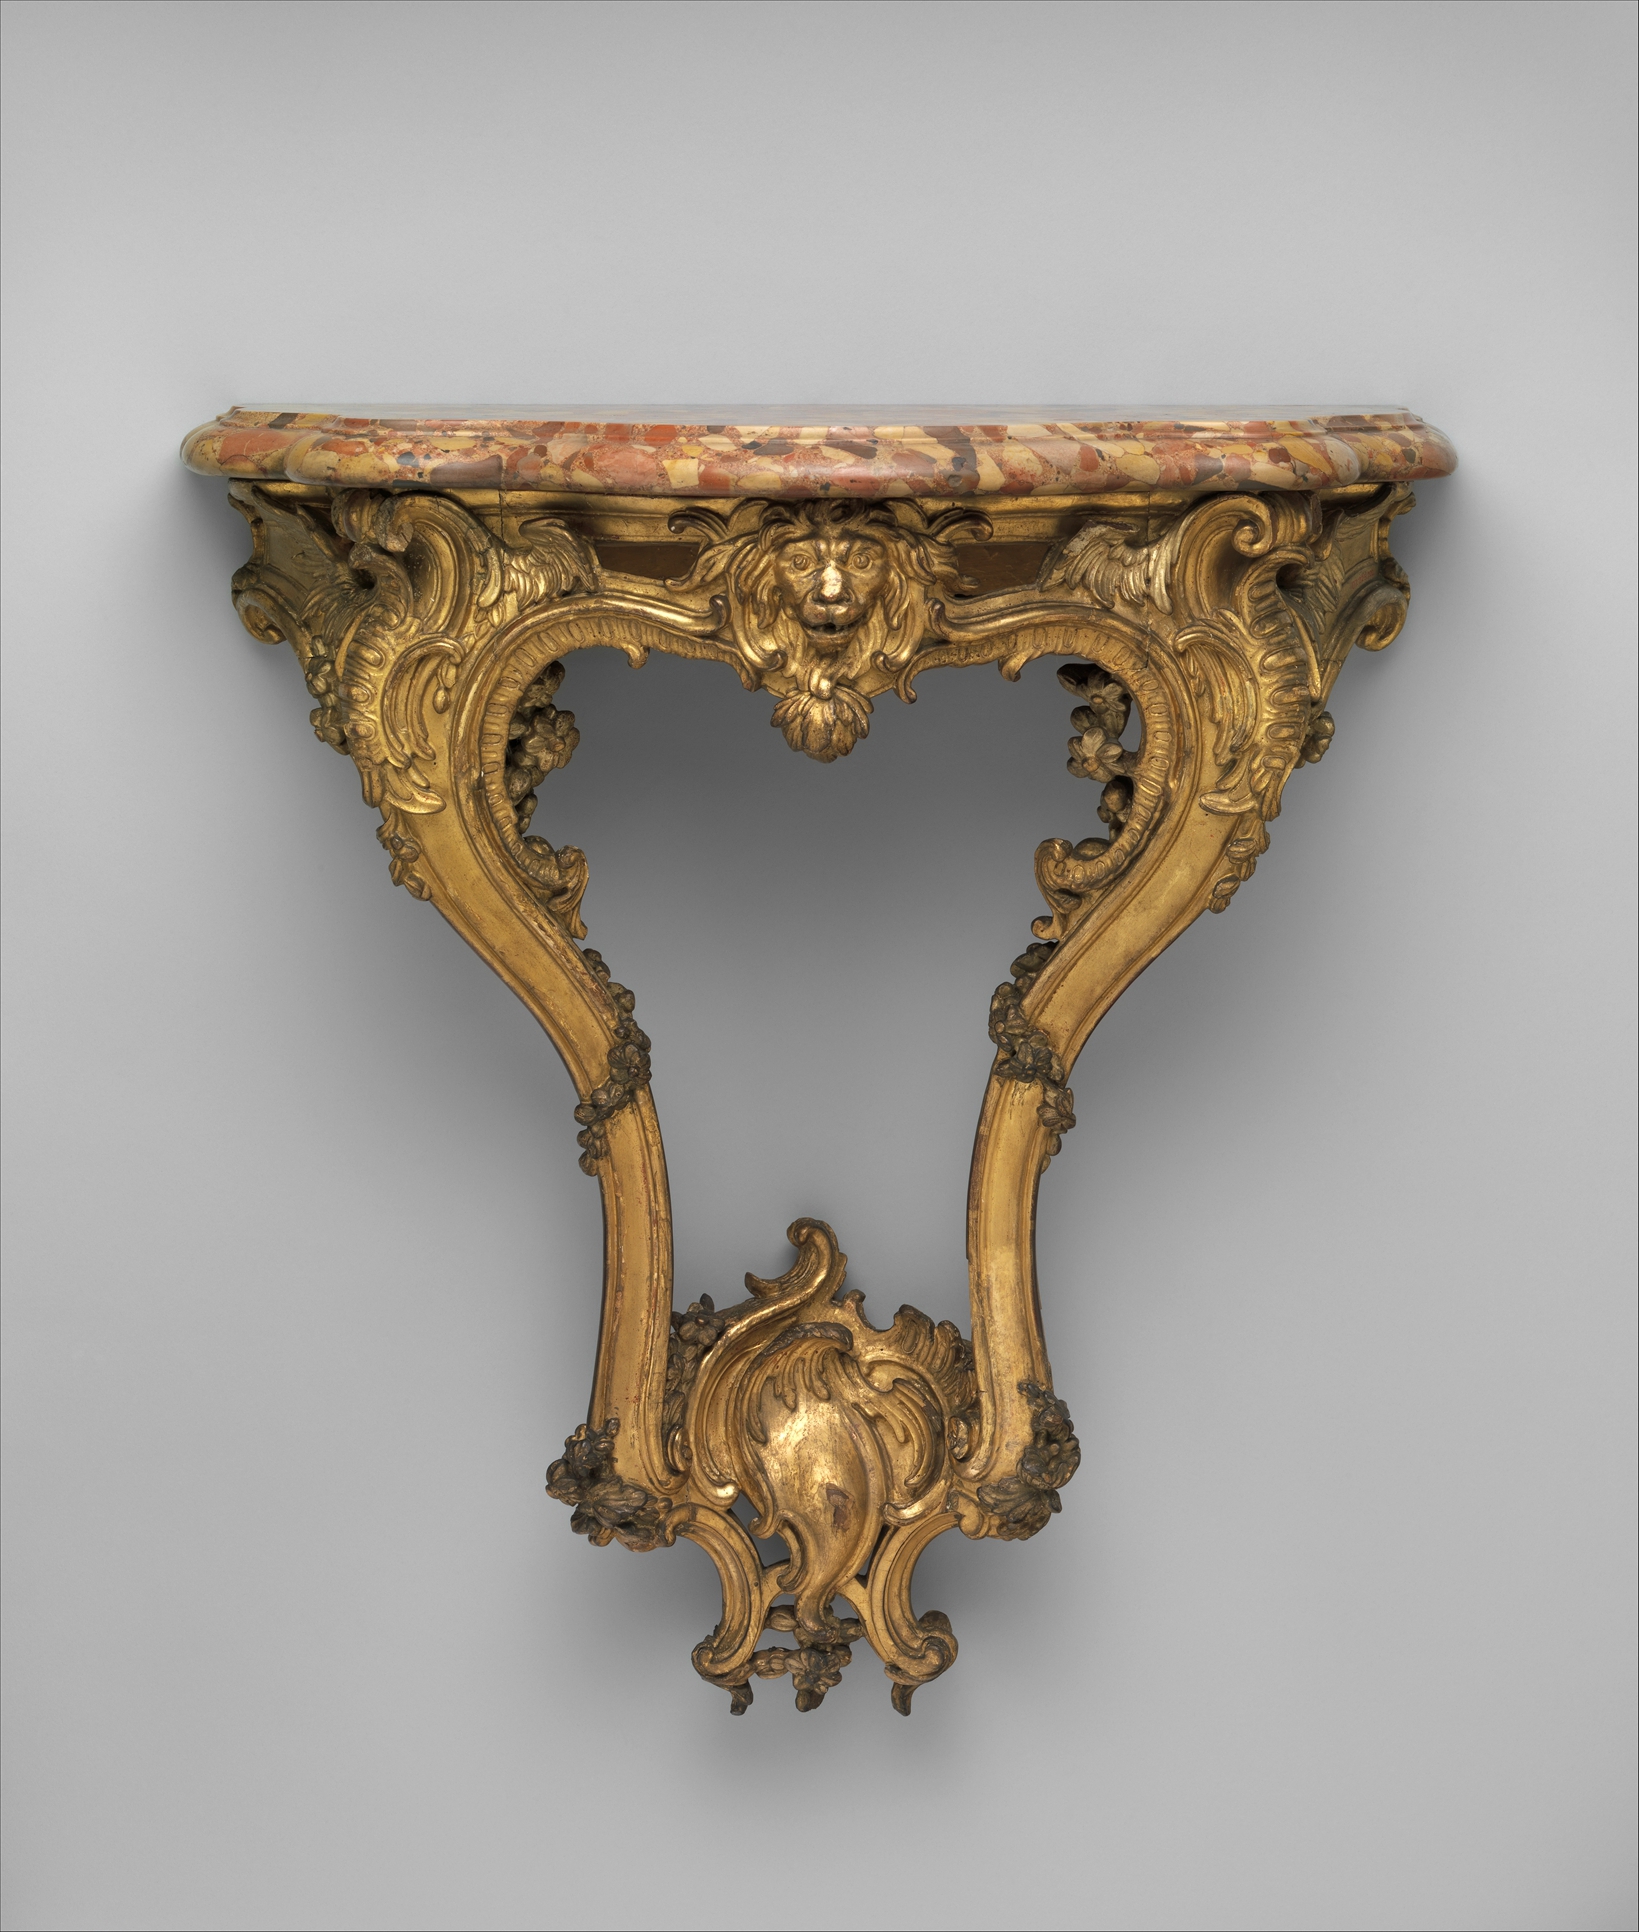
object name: console table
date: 1745-1750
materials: marble, wood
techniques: carving, gilding